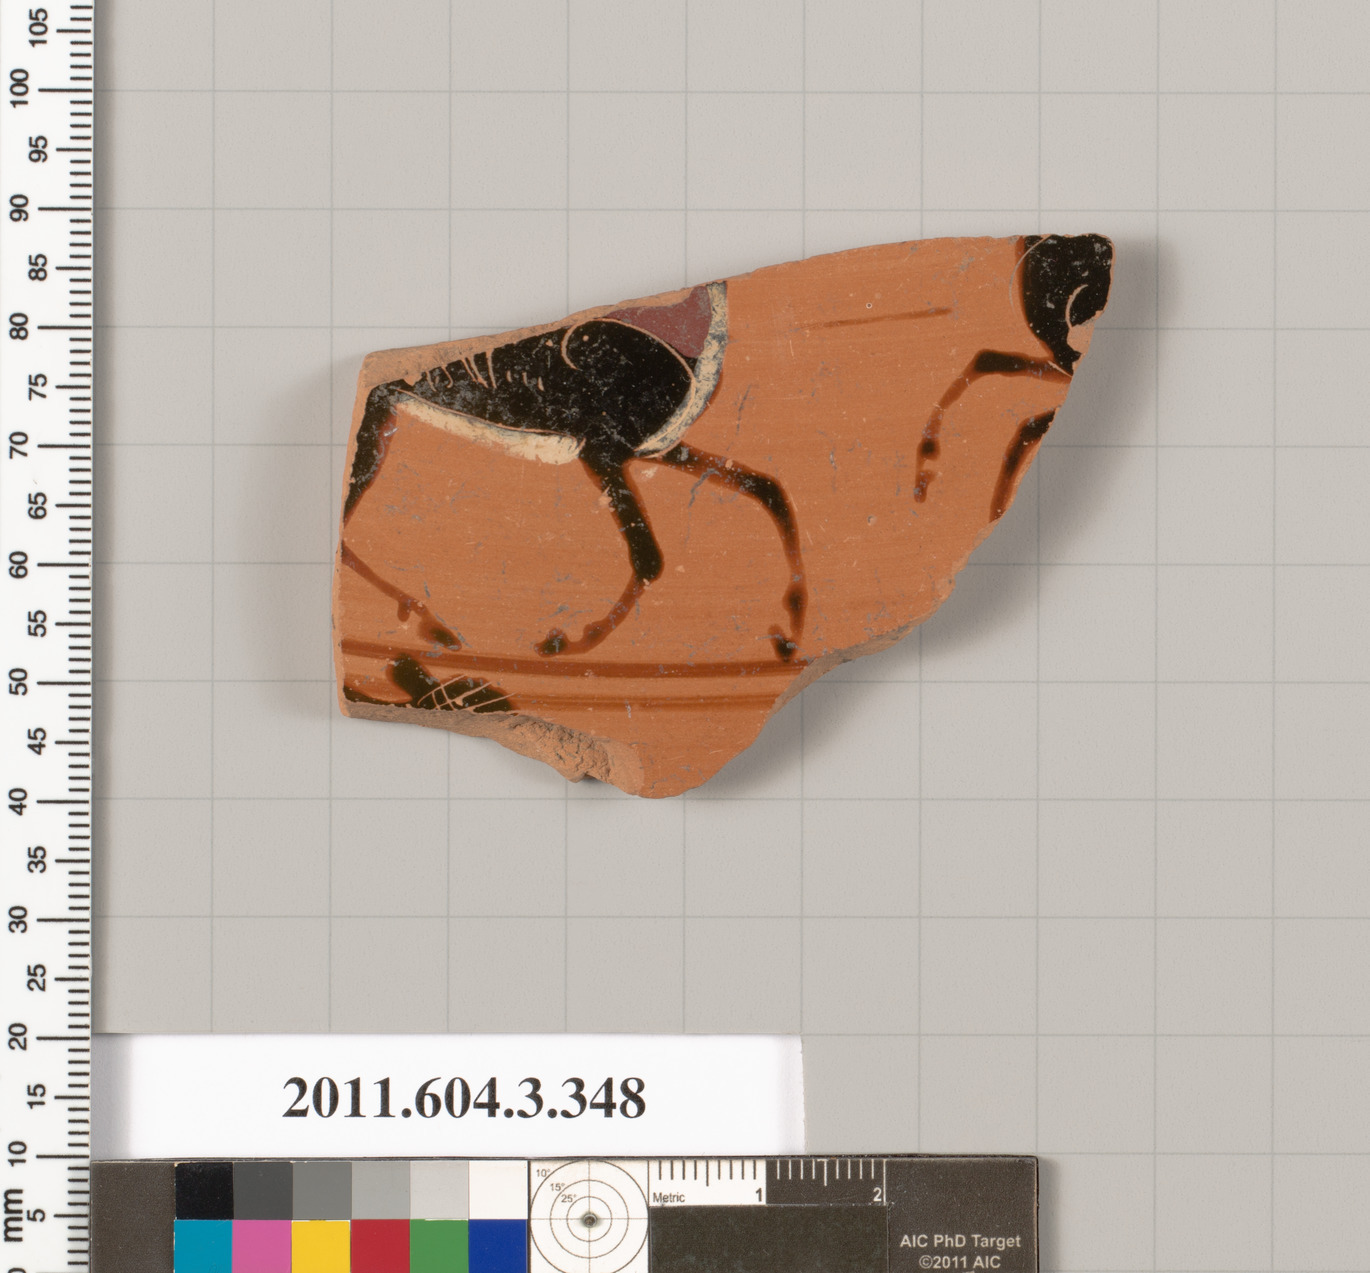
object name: neck amphora fragment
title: Terracotta fragment of a neck-amphora (jar)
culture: greek, attic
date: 575-551 BCE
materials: terracotta